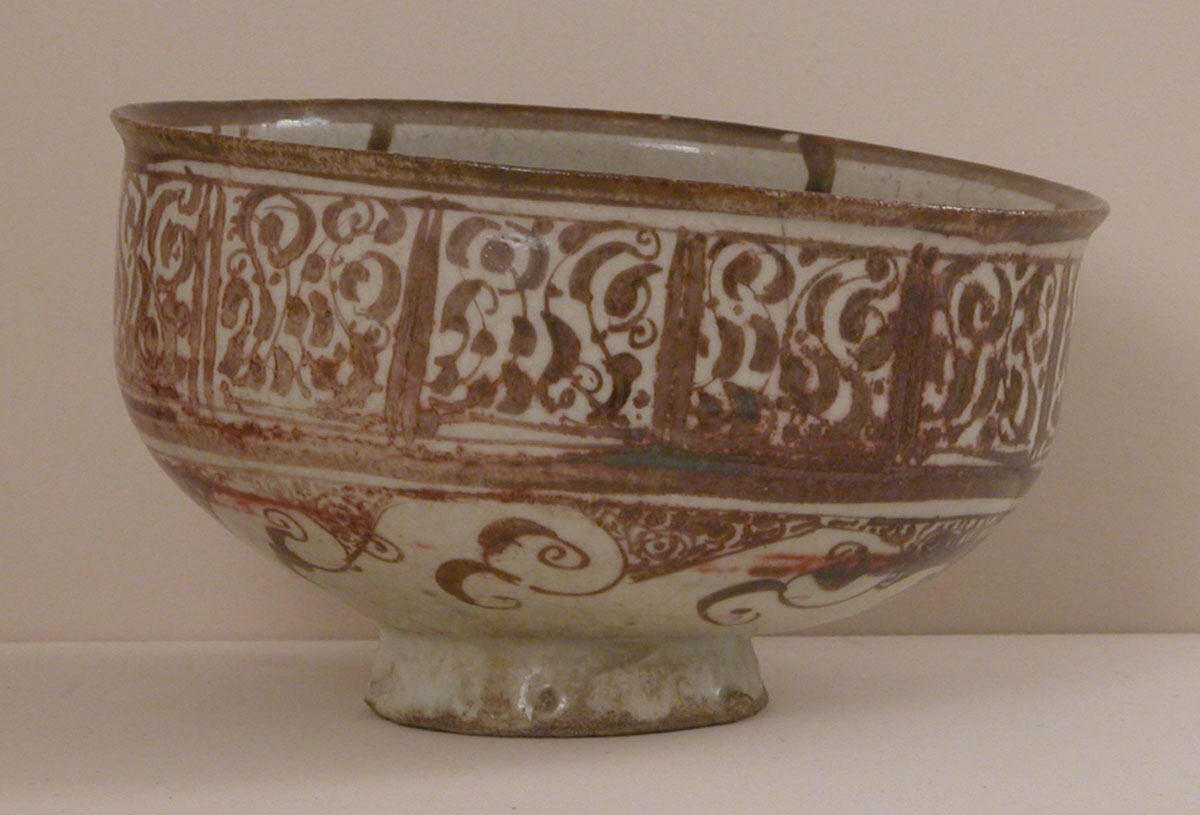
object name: bowl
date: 1101-1300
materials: glaze, stonepaste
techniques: luster painting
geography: iran